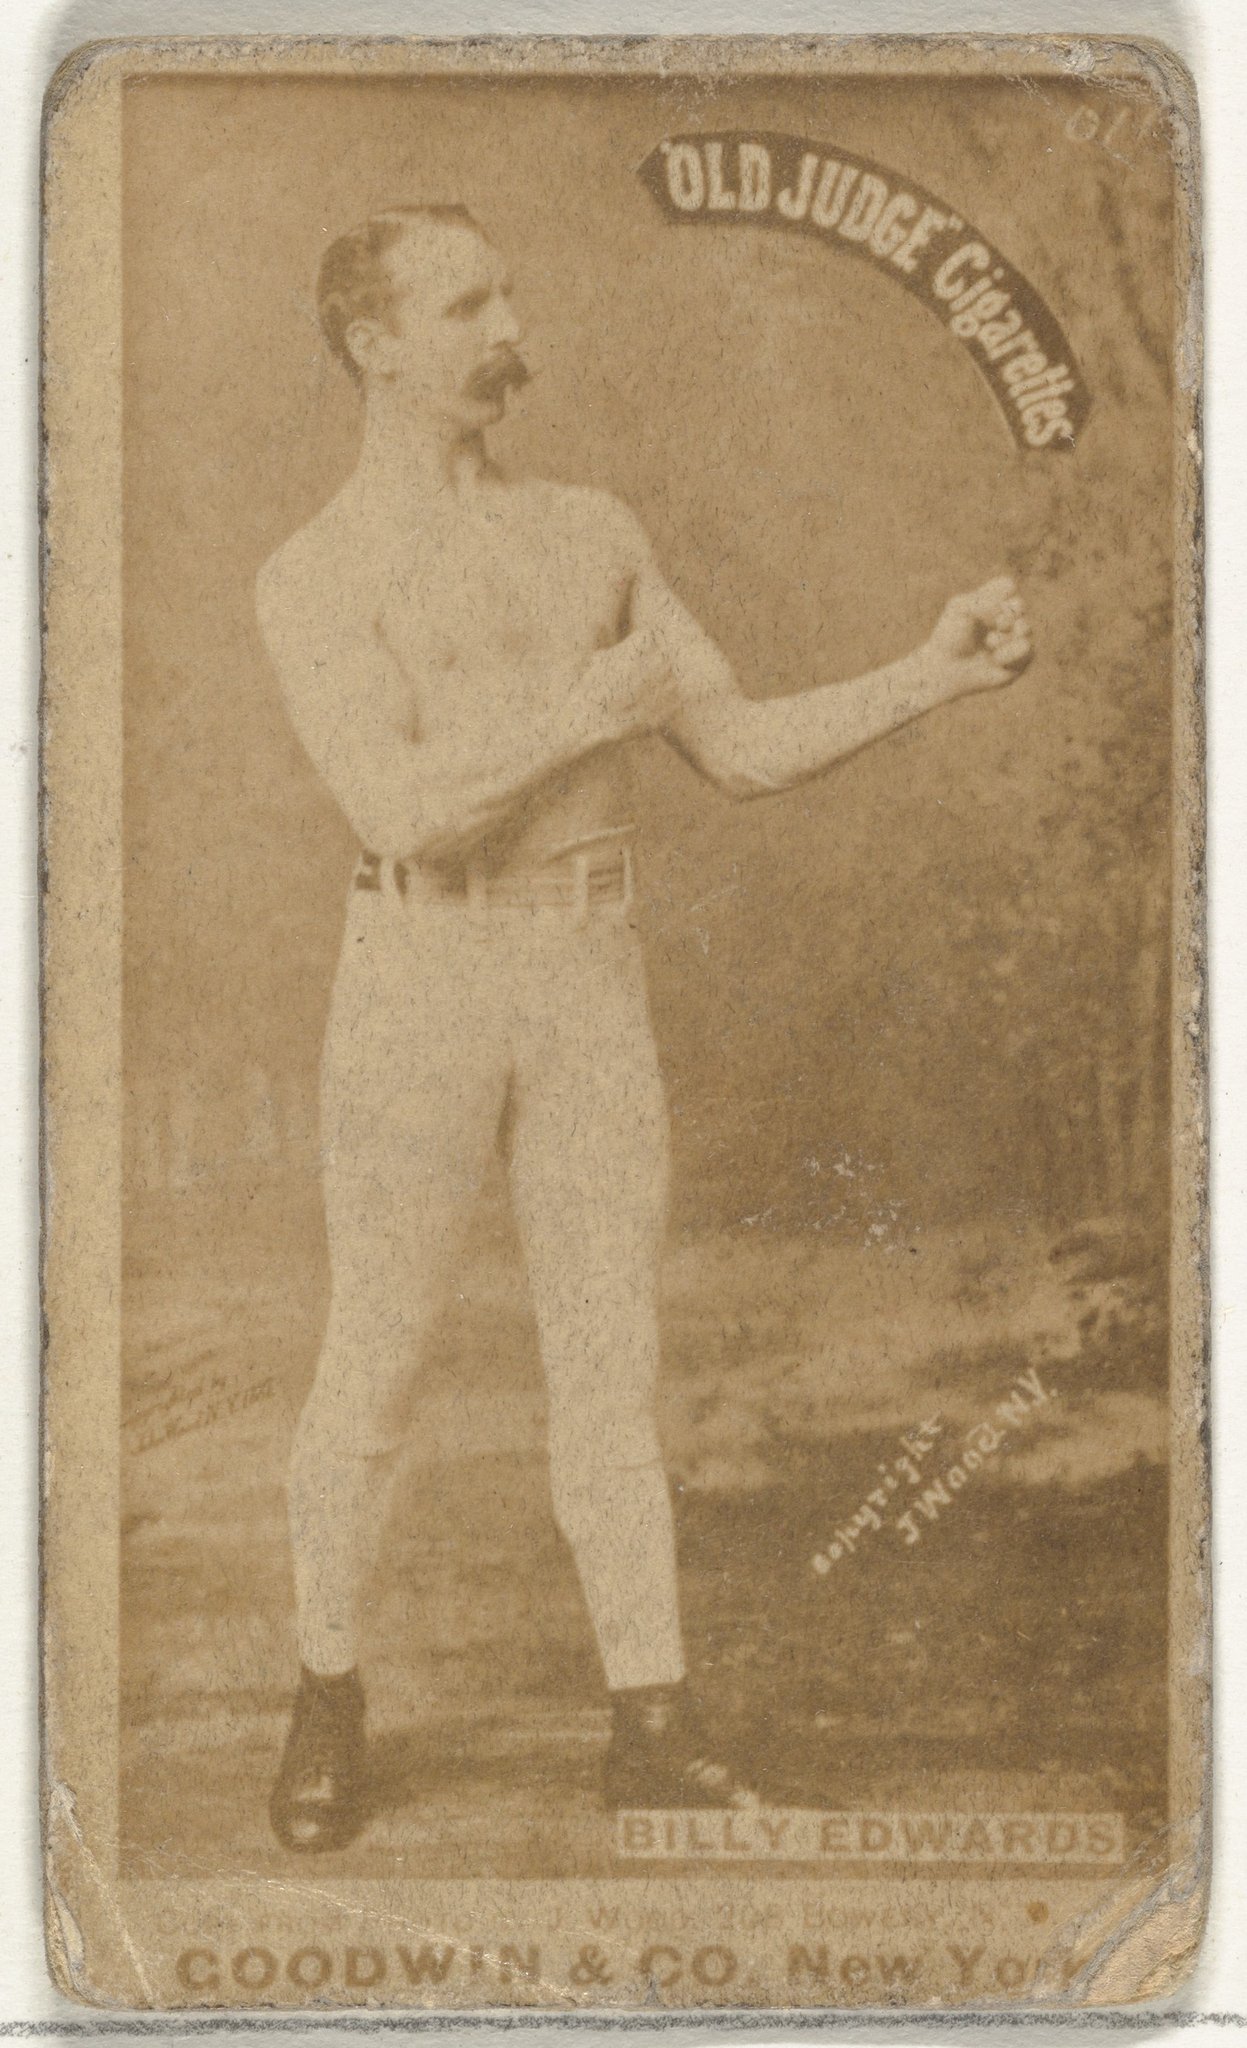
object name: photograph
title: Billy Edwards, from the Celebrities and Prizefighters series (N174) for Old Judge Cigarettes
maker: goodwin & company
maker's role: publisher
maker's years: 1850-1950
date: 1887-1888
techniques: albumen silver print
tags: men,portraits,baseball,athletes